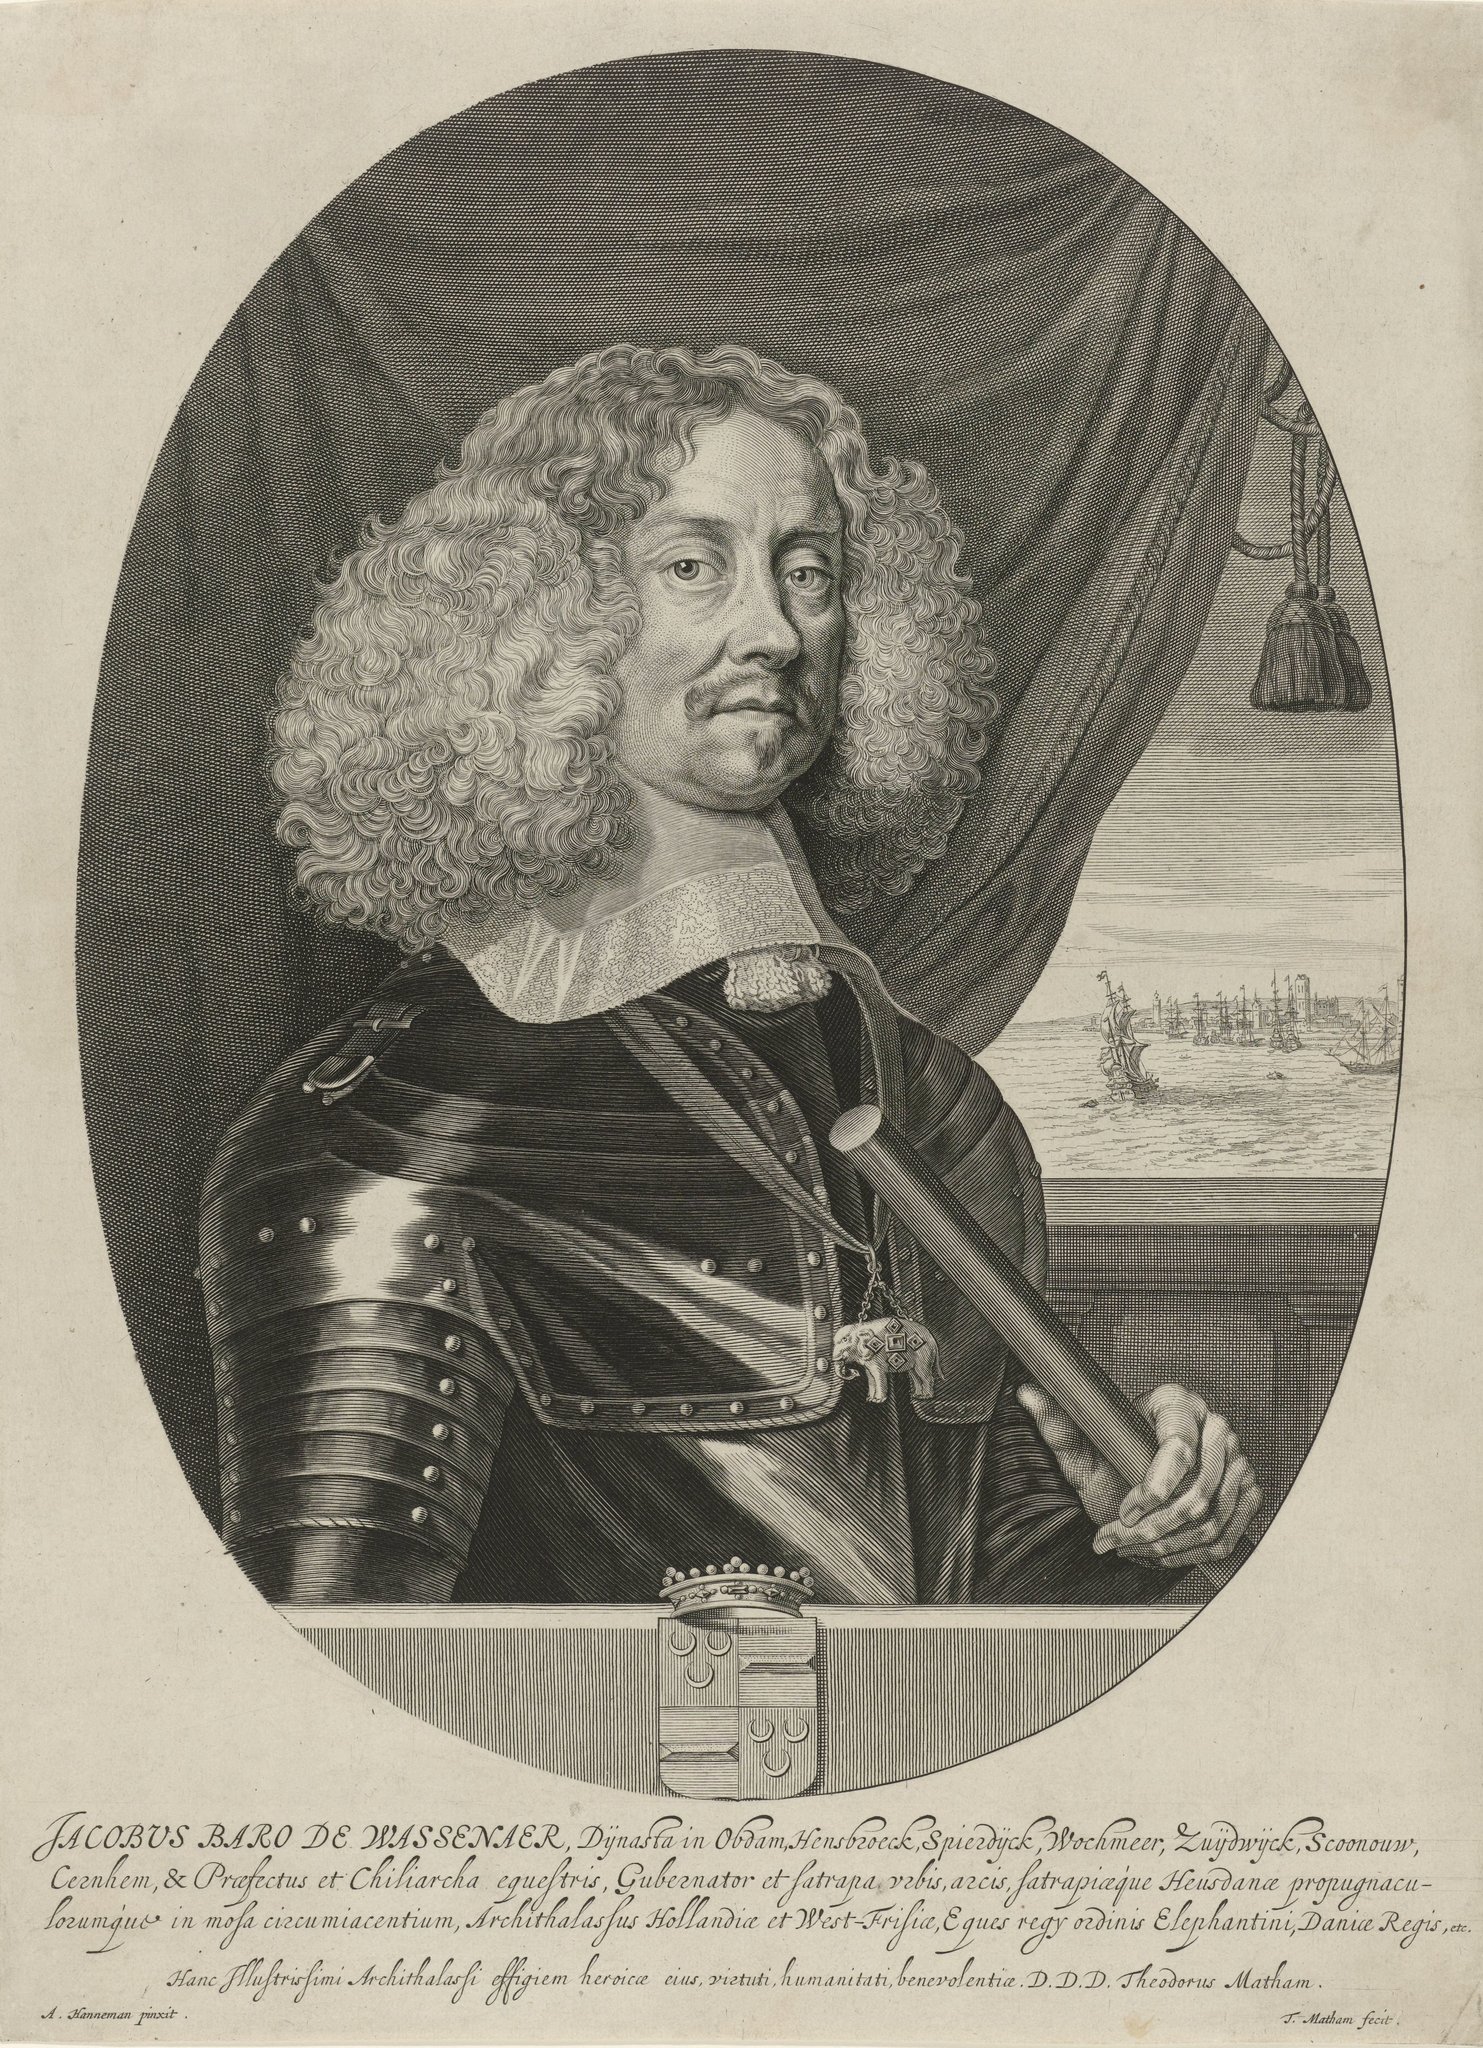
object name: print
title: Portret van Jacob baron van Wassenaer heer van Obdam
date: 1658-1676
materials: paper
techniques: engraving, etching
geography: northern netherlands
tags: jacob baron van wassenaer heer van obdam, knighthood order, baton of general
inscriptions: collector's mark: Lugt 2228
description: Portret van Jacob baron van Wassenaer heer van Obdam, als admiraal, met in zijn hand een commandostaf en om zijn hals het teken van de Deense Orde van de Olifant. Op de achtergrond zijn vloot. Middenonder zijn wapen.